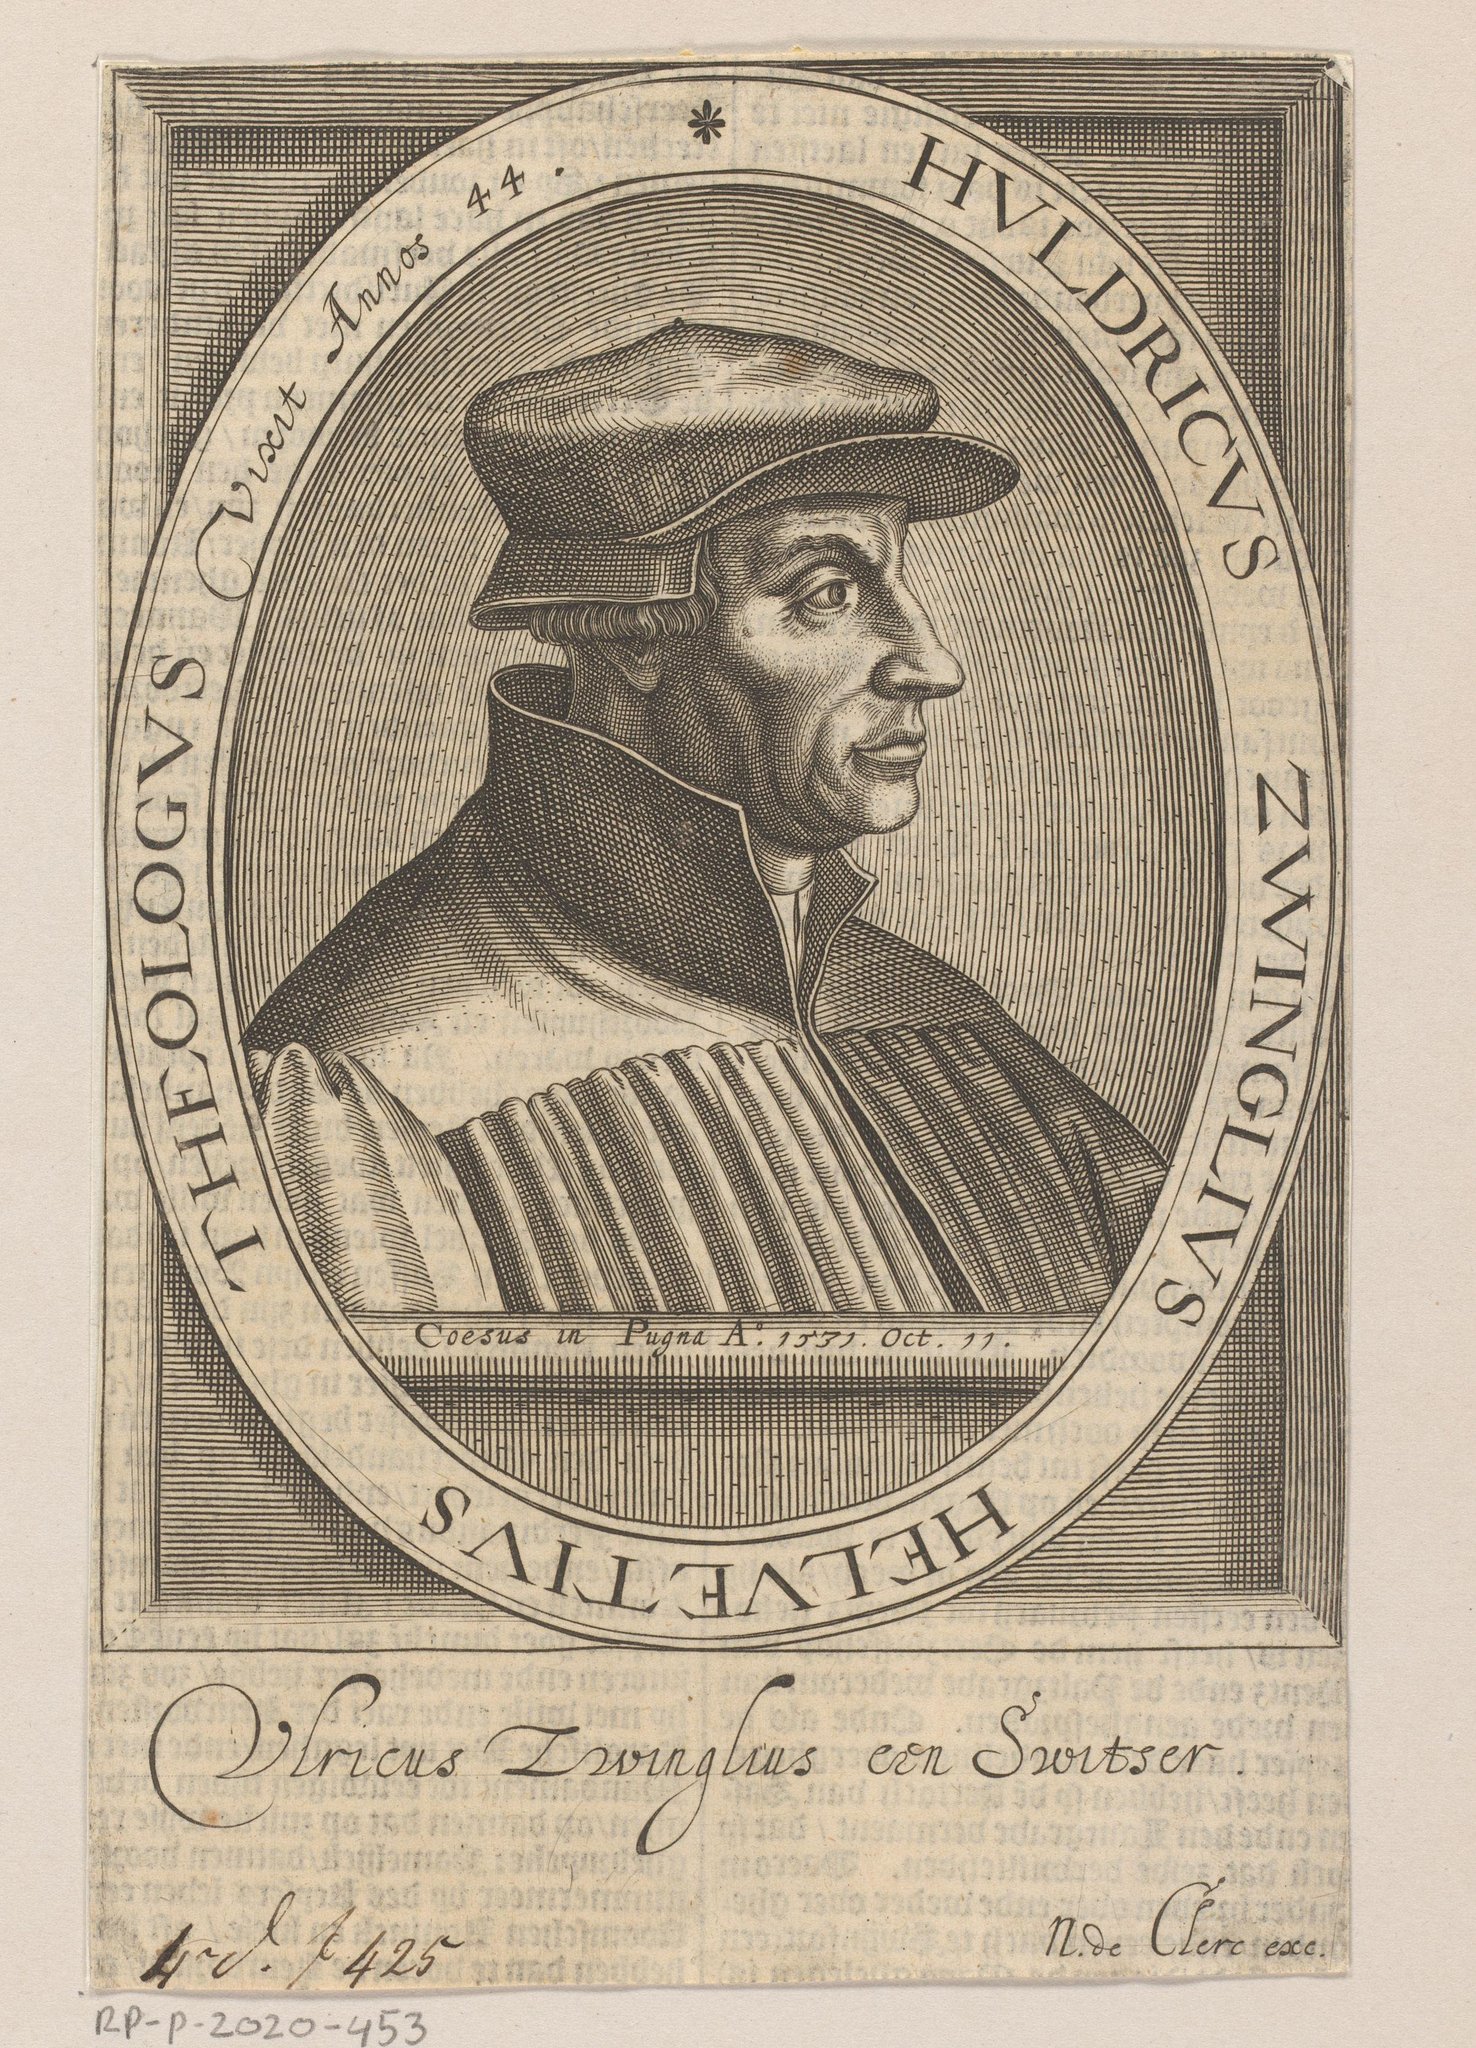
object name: print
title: Portret van Ulrich Zwingli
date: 1611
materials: paper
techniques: engraving, letterpress printing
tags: theologian, historical persons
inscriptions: inscription: ‘4 [...] 425’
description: Prent waarschijnlijk gebruikt in: Sleidanus, Johannes en Deelen, Walter. Warachtige beschryvinge hoe datte met de religie gestaen heeft (...). Rotterdam: Gillis Pieters, Delft: Nicolaes de Clerck, 1611.